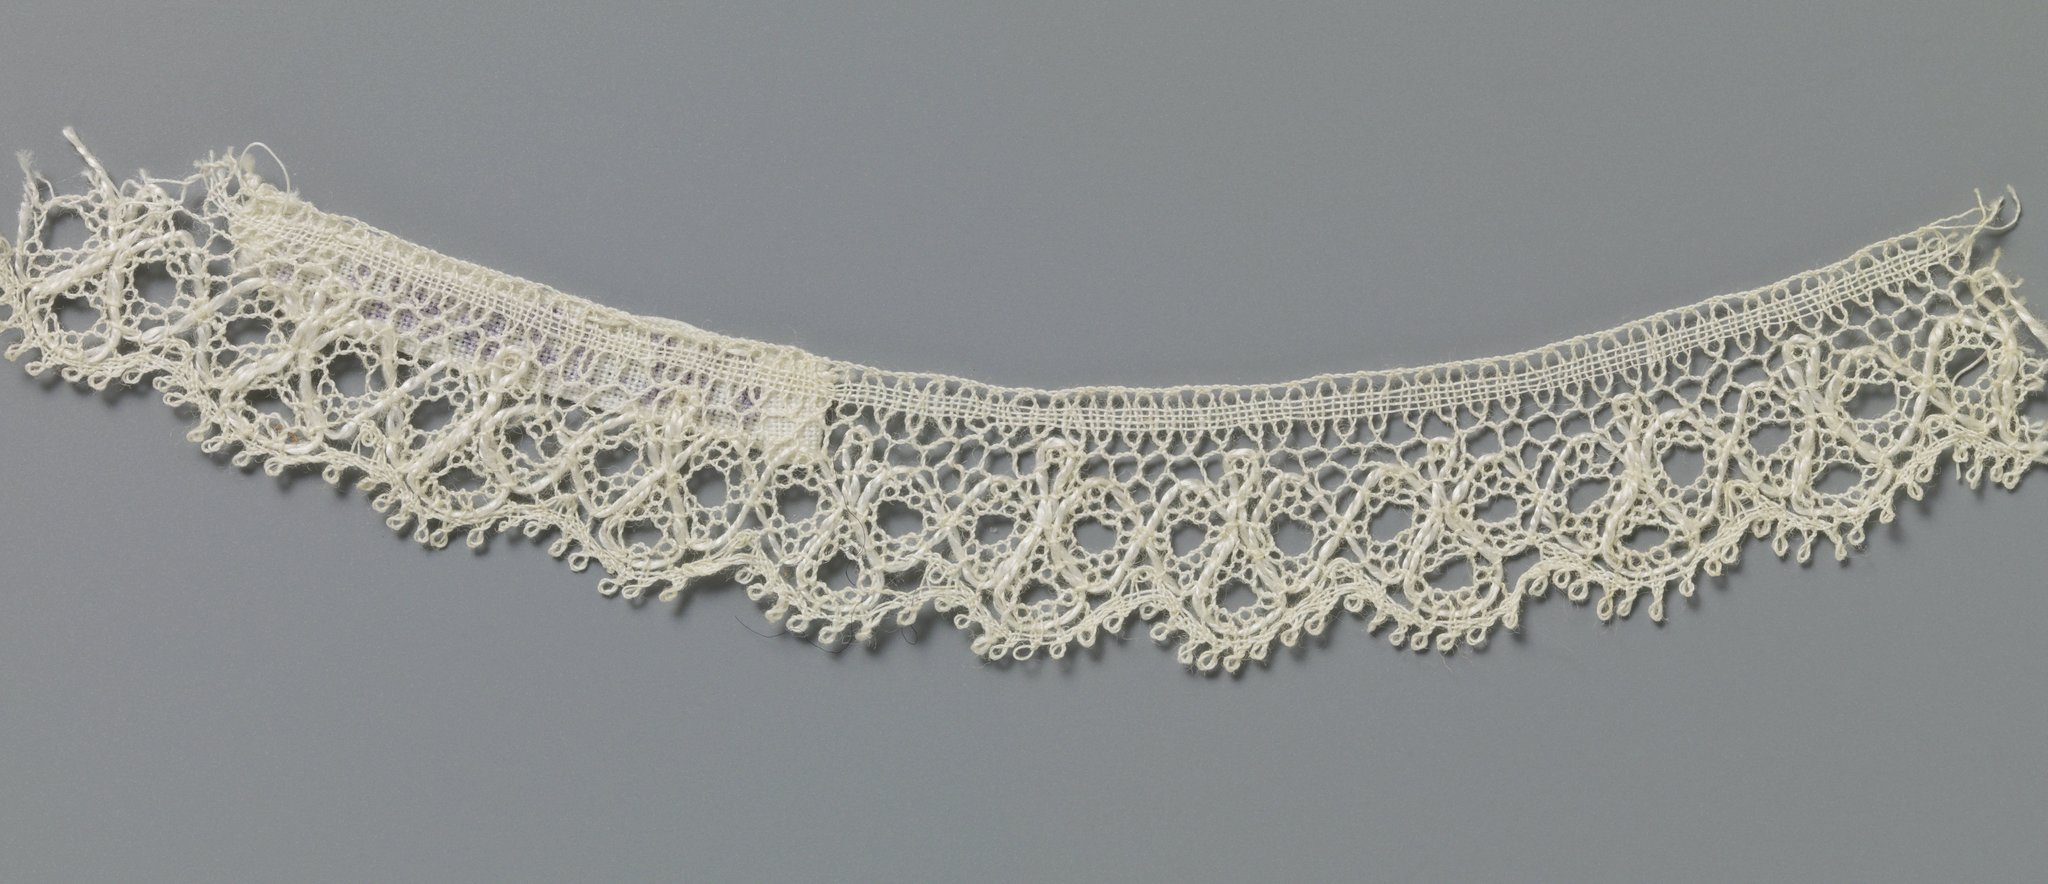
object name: strip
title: Strook kloskant met klavertjes drie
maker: Anonymous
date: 1800-1899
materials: cotton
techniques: lace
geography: buckingham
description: Strook naturelkleurige kloskant, Buckingham-kant. Het zich herhalende patroon bestaat uit rij aaneengeschakelde klavertjes drie, die aan een steeltje recht naar beneden hangen. Boven de klavertjes loopt een zeer smalle baan gemaakt met een maasgrond, een tulegrond. Daaronder bestaat de strook uit een siergrond, een rozengrond waarin met dikke en glimmende contourdraden de klavertjes zijn gemaakt. Een zeer smal bandje vormt al golvend, onder elk klavertje een halfrond schulpje, dat is afgewerkt met picots. De bovenzijde van de strook is recht afgewerkt.